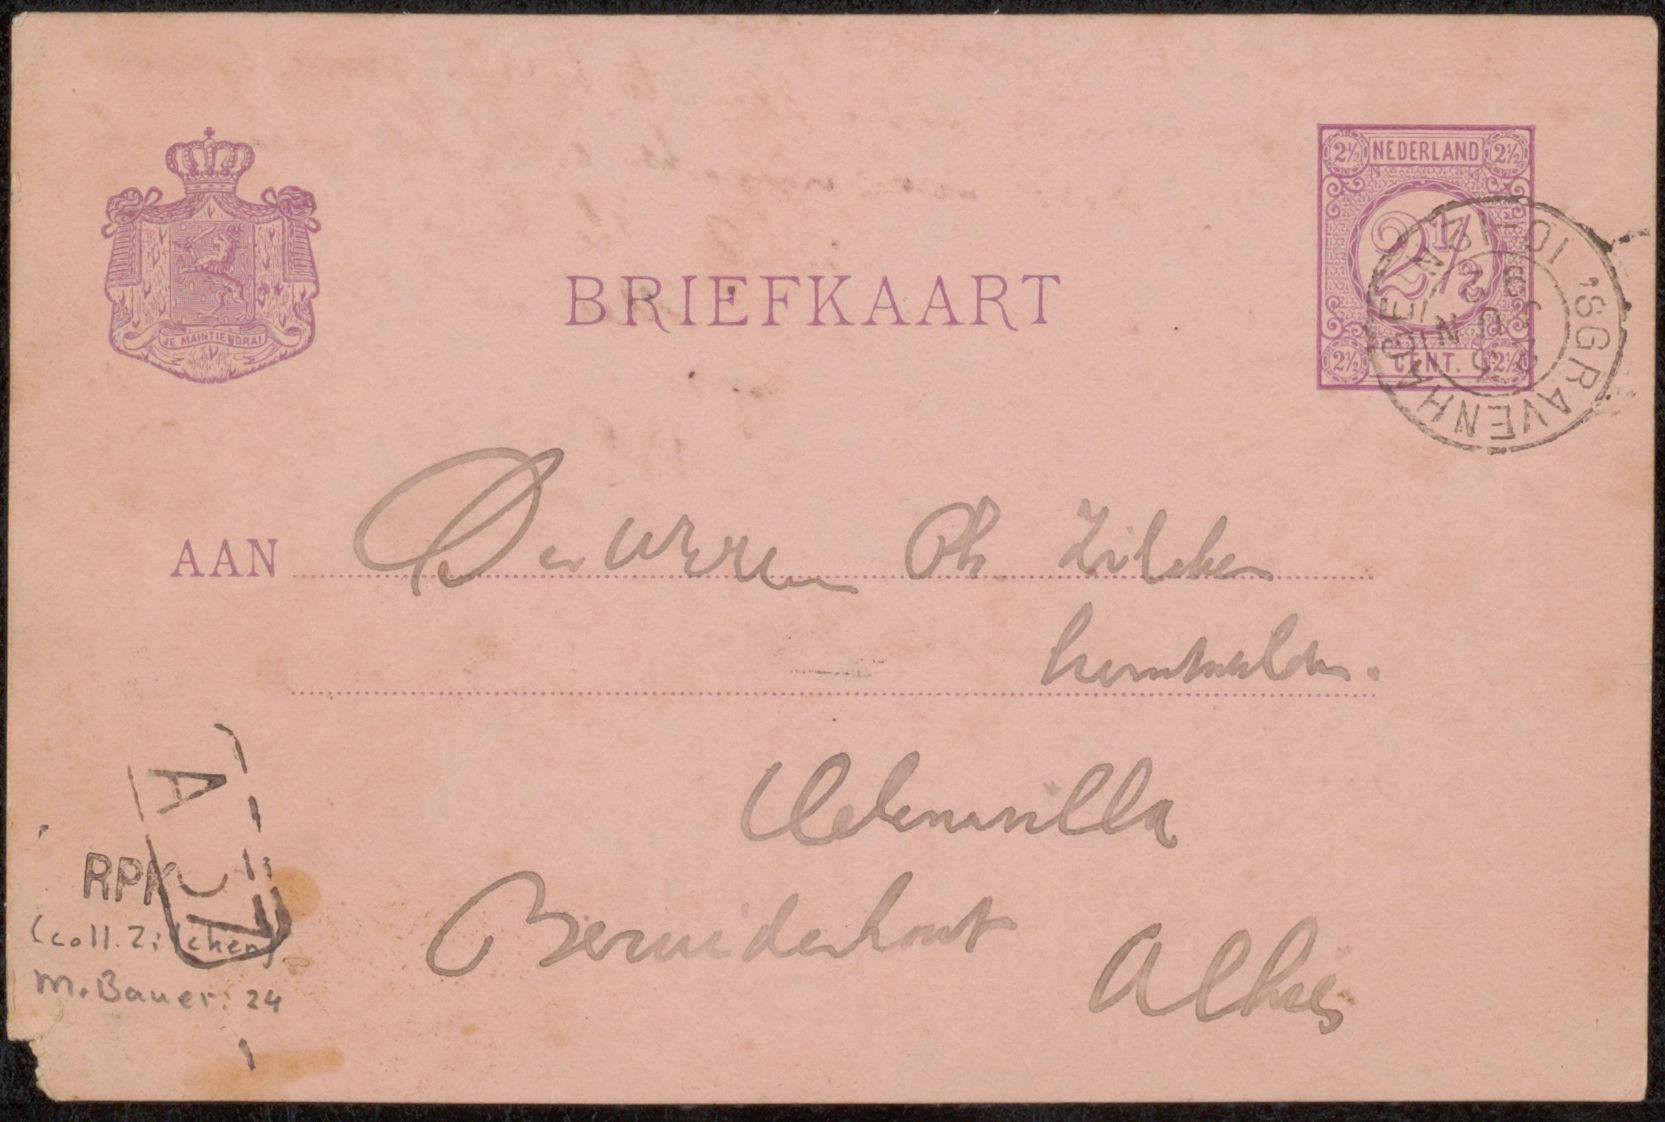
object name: postcard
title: Briefkaart aan Philip Zilcken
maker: marius bauer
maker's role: draughtsman, print maker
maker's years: 1867-1932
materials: cardboard, ink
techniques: pen, writing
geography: the hague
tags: painter, philip zilcken, antwerp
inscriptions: collector's mark: ‘RPK’